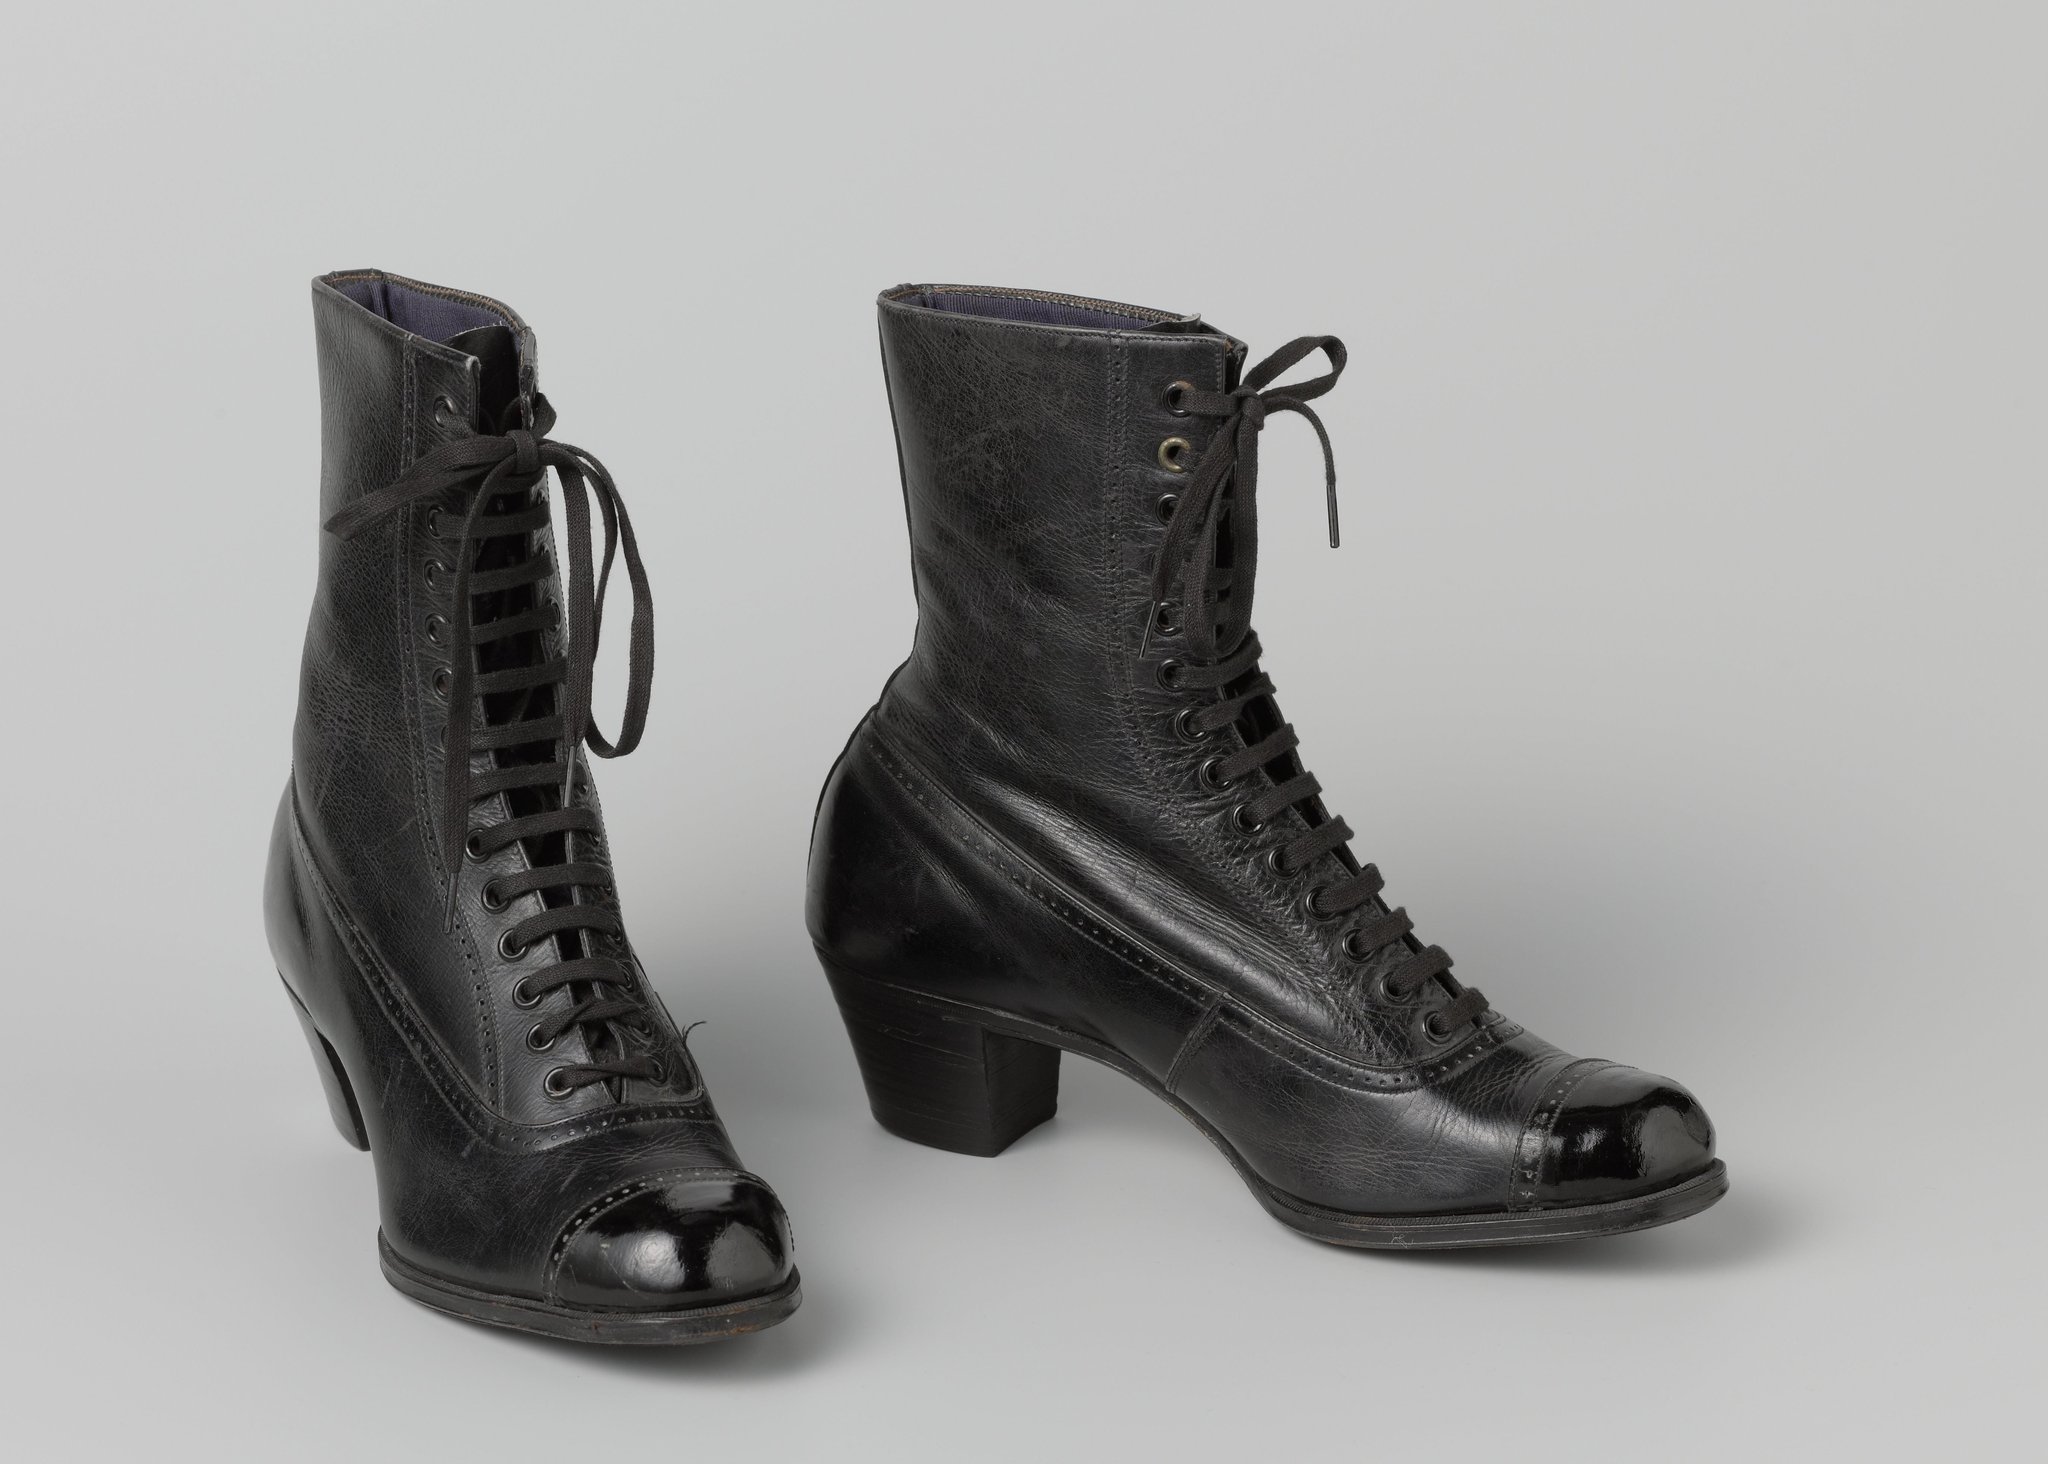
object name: balmoral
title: Rijglaars van zwarte boxcalf met lakneuzen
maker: Anonymous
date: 1915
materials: leather, cotton, linen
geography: england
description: Linker rijglaars van zwart kalfsleer met lakneuzen. Model: sportief met ronde neus en Weense hak van laagjes leer. Het neusstuk is van lak. Naden hierlangs en op de rest van de schacht met geperforeerde randjes. Adres (onduidelijk, op de zool): The Emza Shoe/Wettig deponeerd